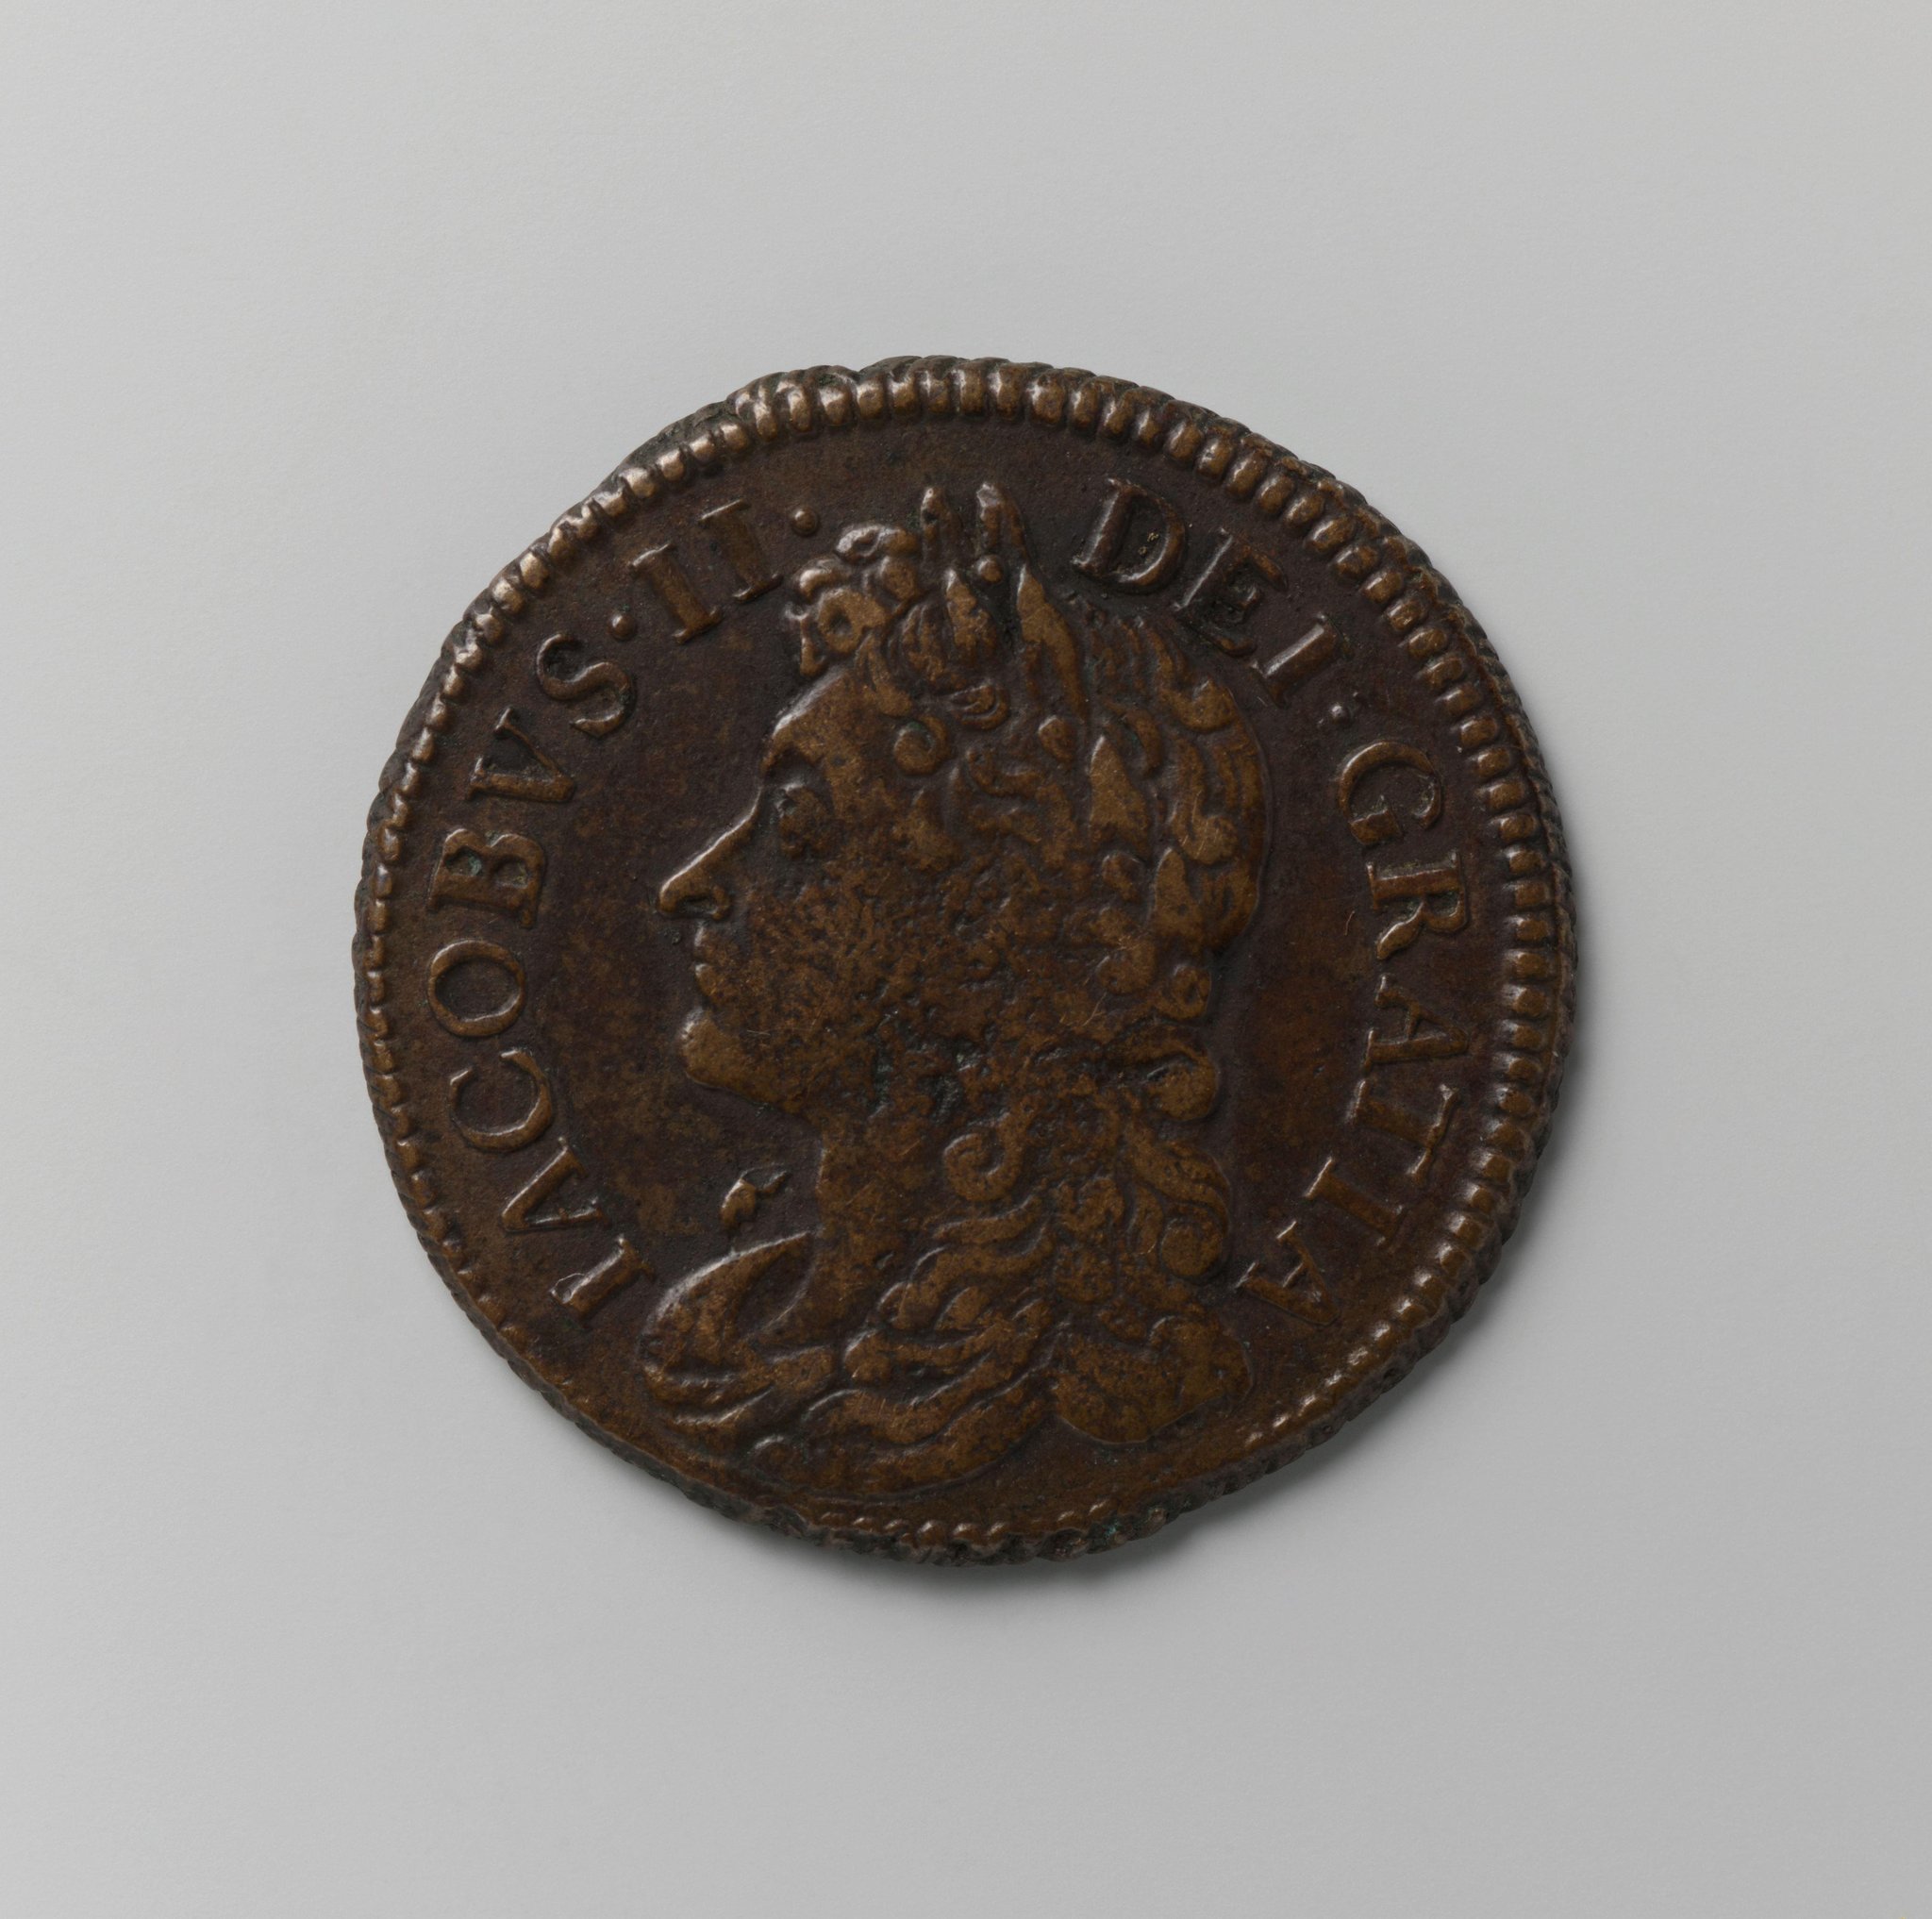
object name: coin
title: Ierland, Jacobus II, 6 pence, juli 1689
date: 1689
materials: bronze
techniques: striking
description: Bronzen munt. Voorzijde: gelauwerd hoofd van de vorst naar links. Keerzijde: tussen letters J en R kroon op twee gekruiste scepters.Jaartal bovenaan in omschrift, maand-aanduiding onder kroon, Waarde-aanduiding VI boven kroon. Kabelrand. Gun-money.